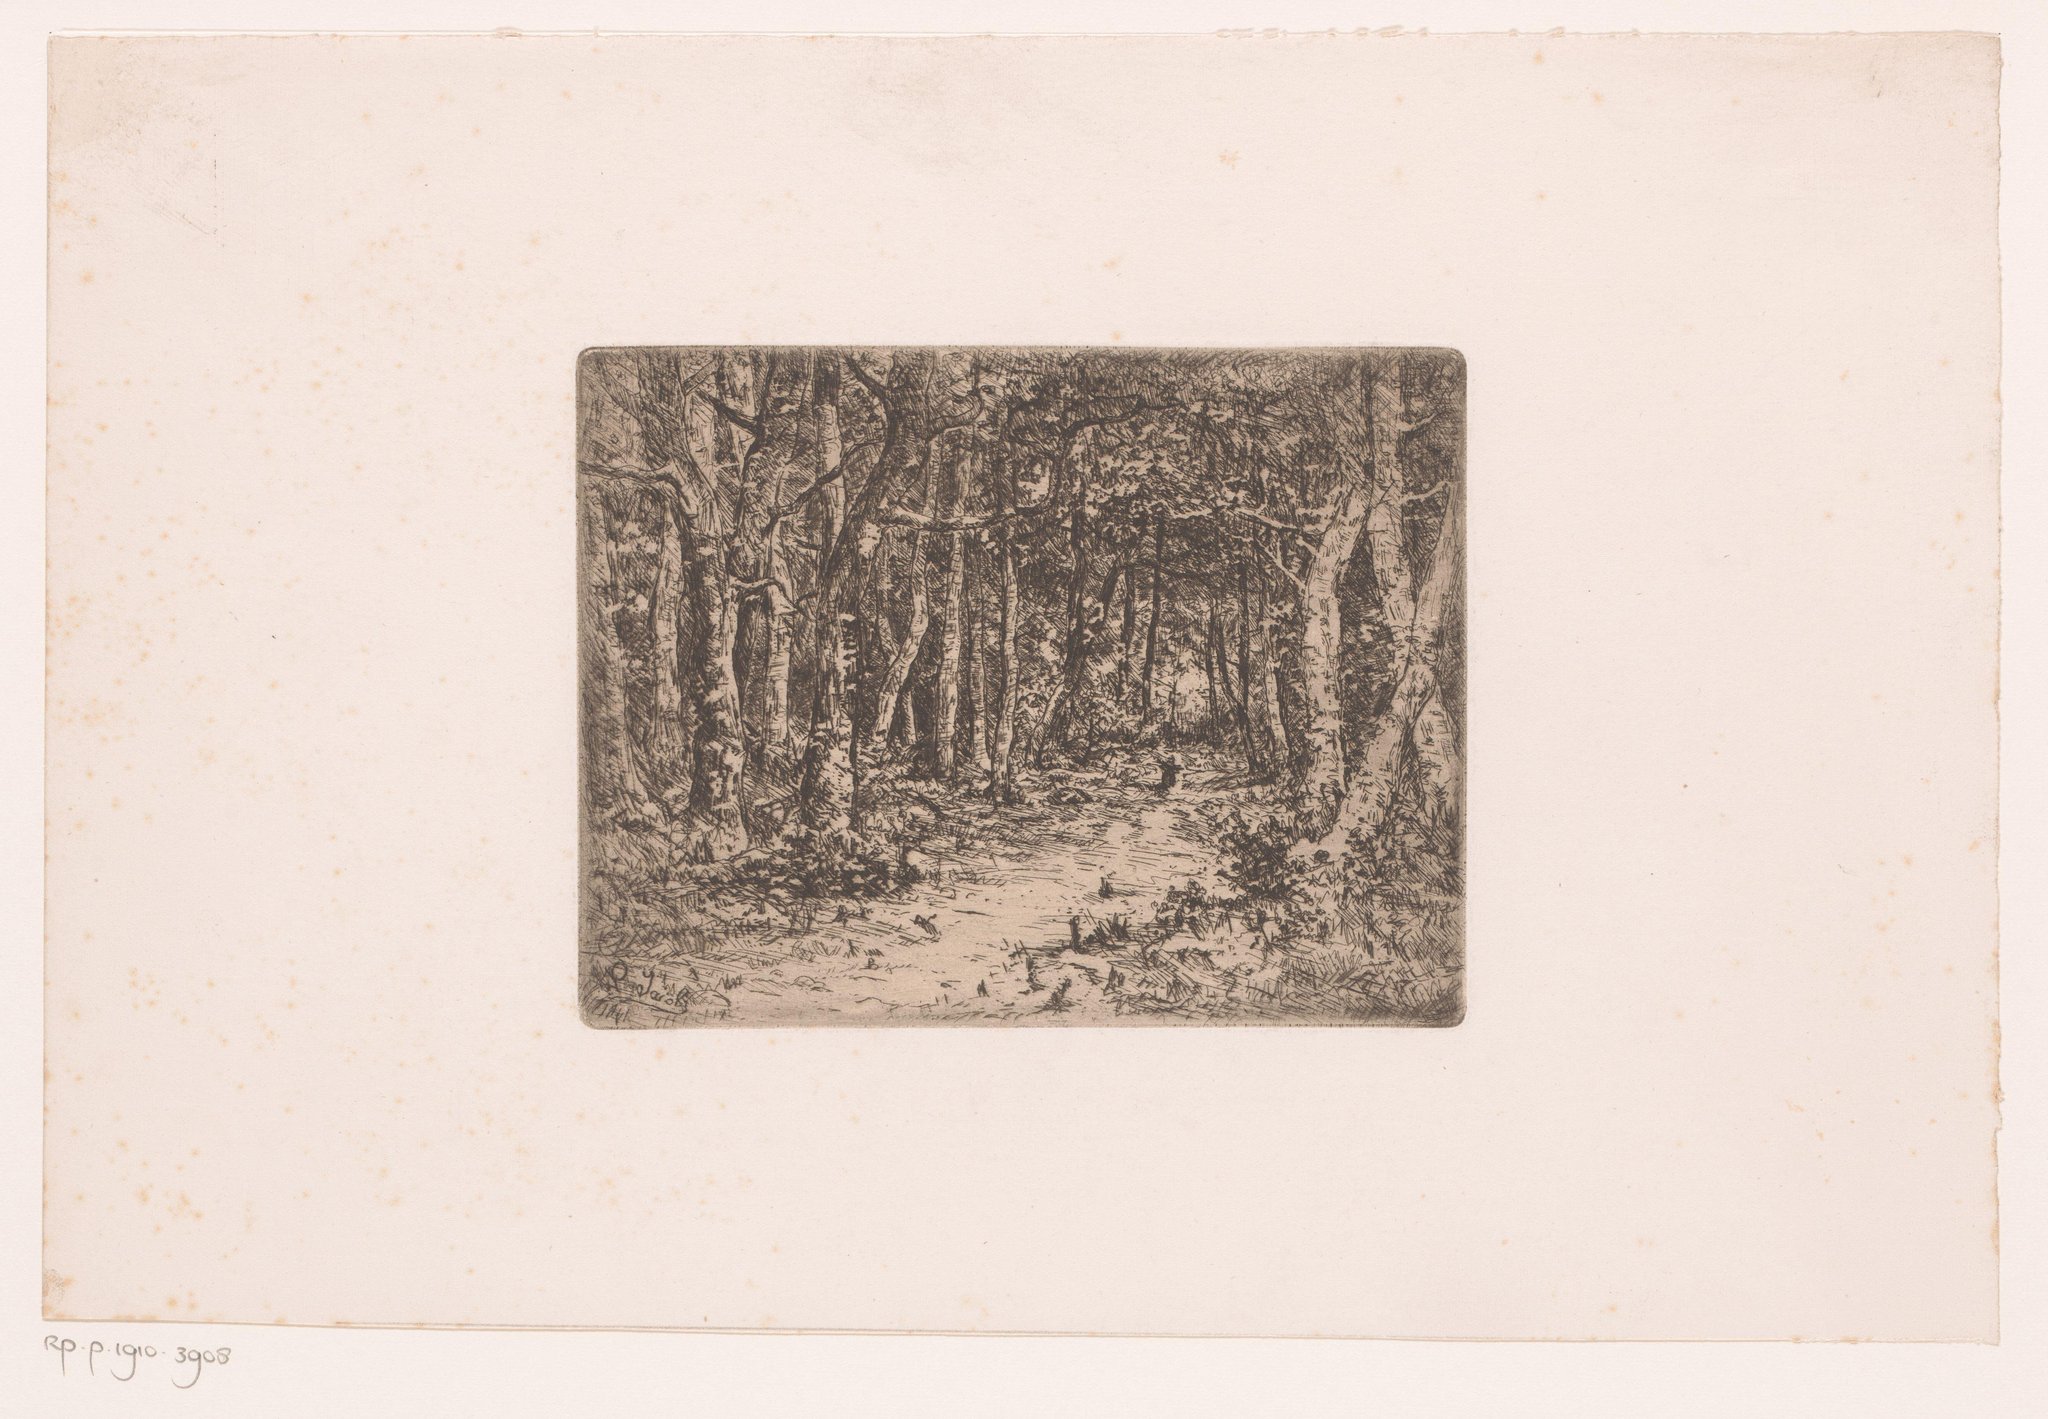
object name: print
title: Pad in dicht begroeid bos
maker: louis adolphe jacobs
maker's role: painter, print maker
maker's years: 1855-1929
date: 1865-1910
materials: paper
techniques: drypoint, etching, intaglio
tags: forest path or lane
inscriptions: collector's mark: Lugt 2228